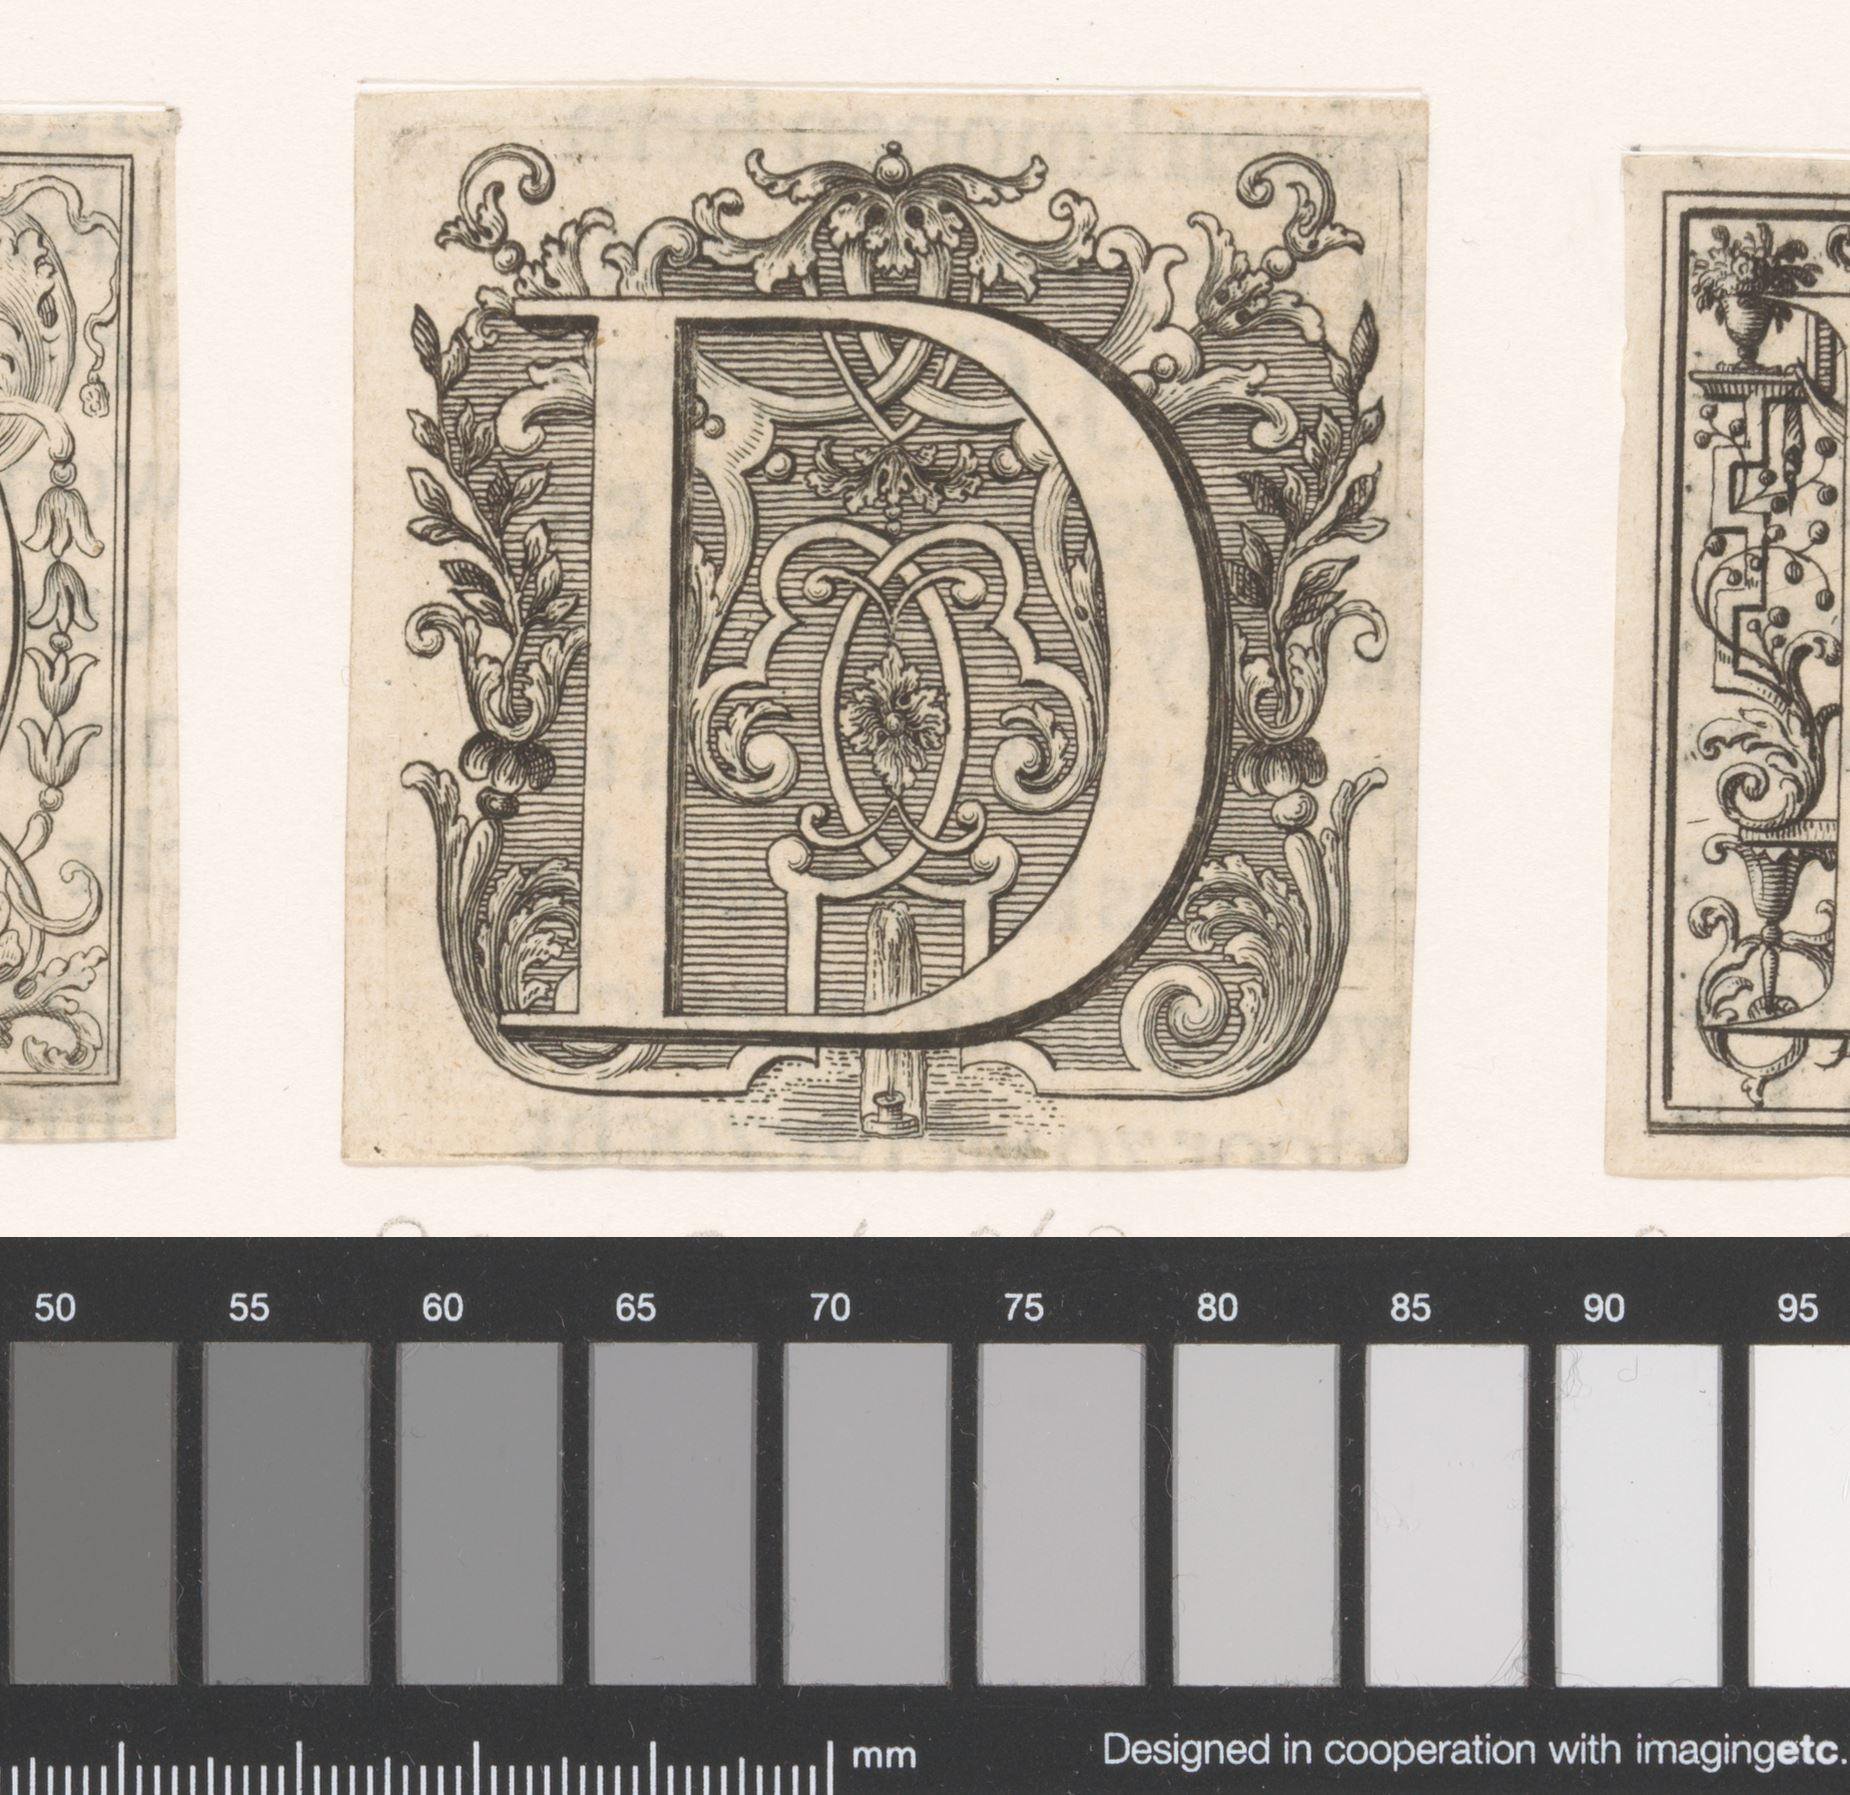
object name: book illustration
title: Letter D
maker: Anonymous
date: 1700-1799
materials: paper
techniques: etching, letterpress printing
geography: netherlands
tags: fancy letters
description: Letter D tegen een achtergrond met vlechtwerk en een fontein.